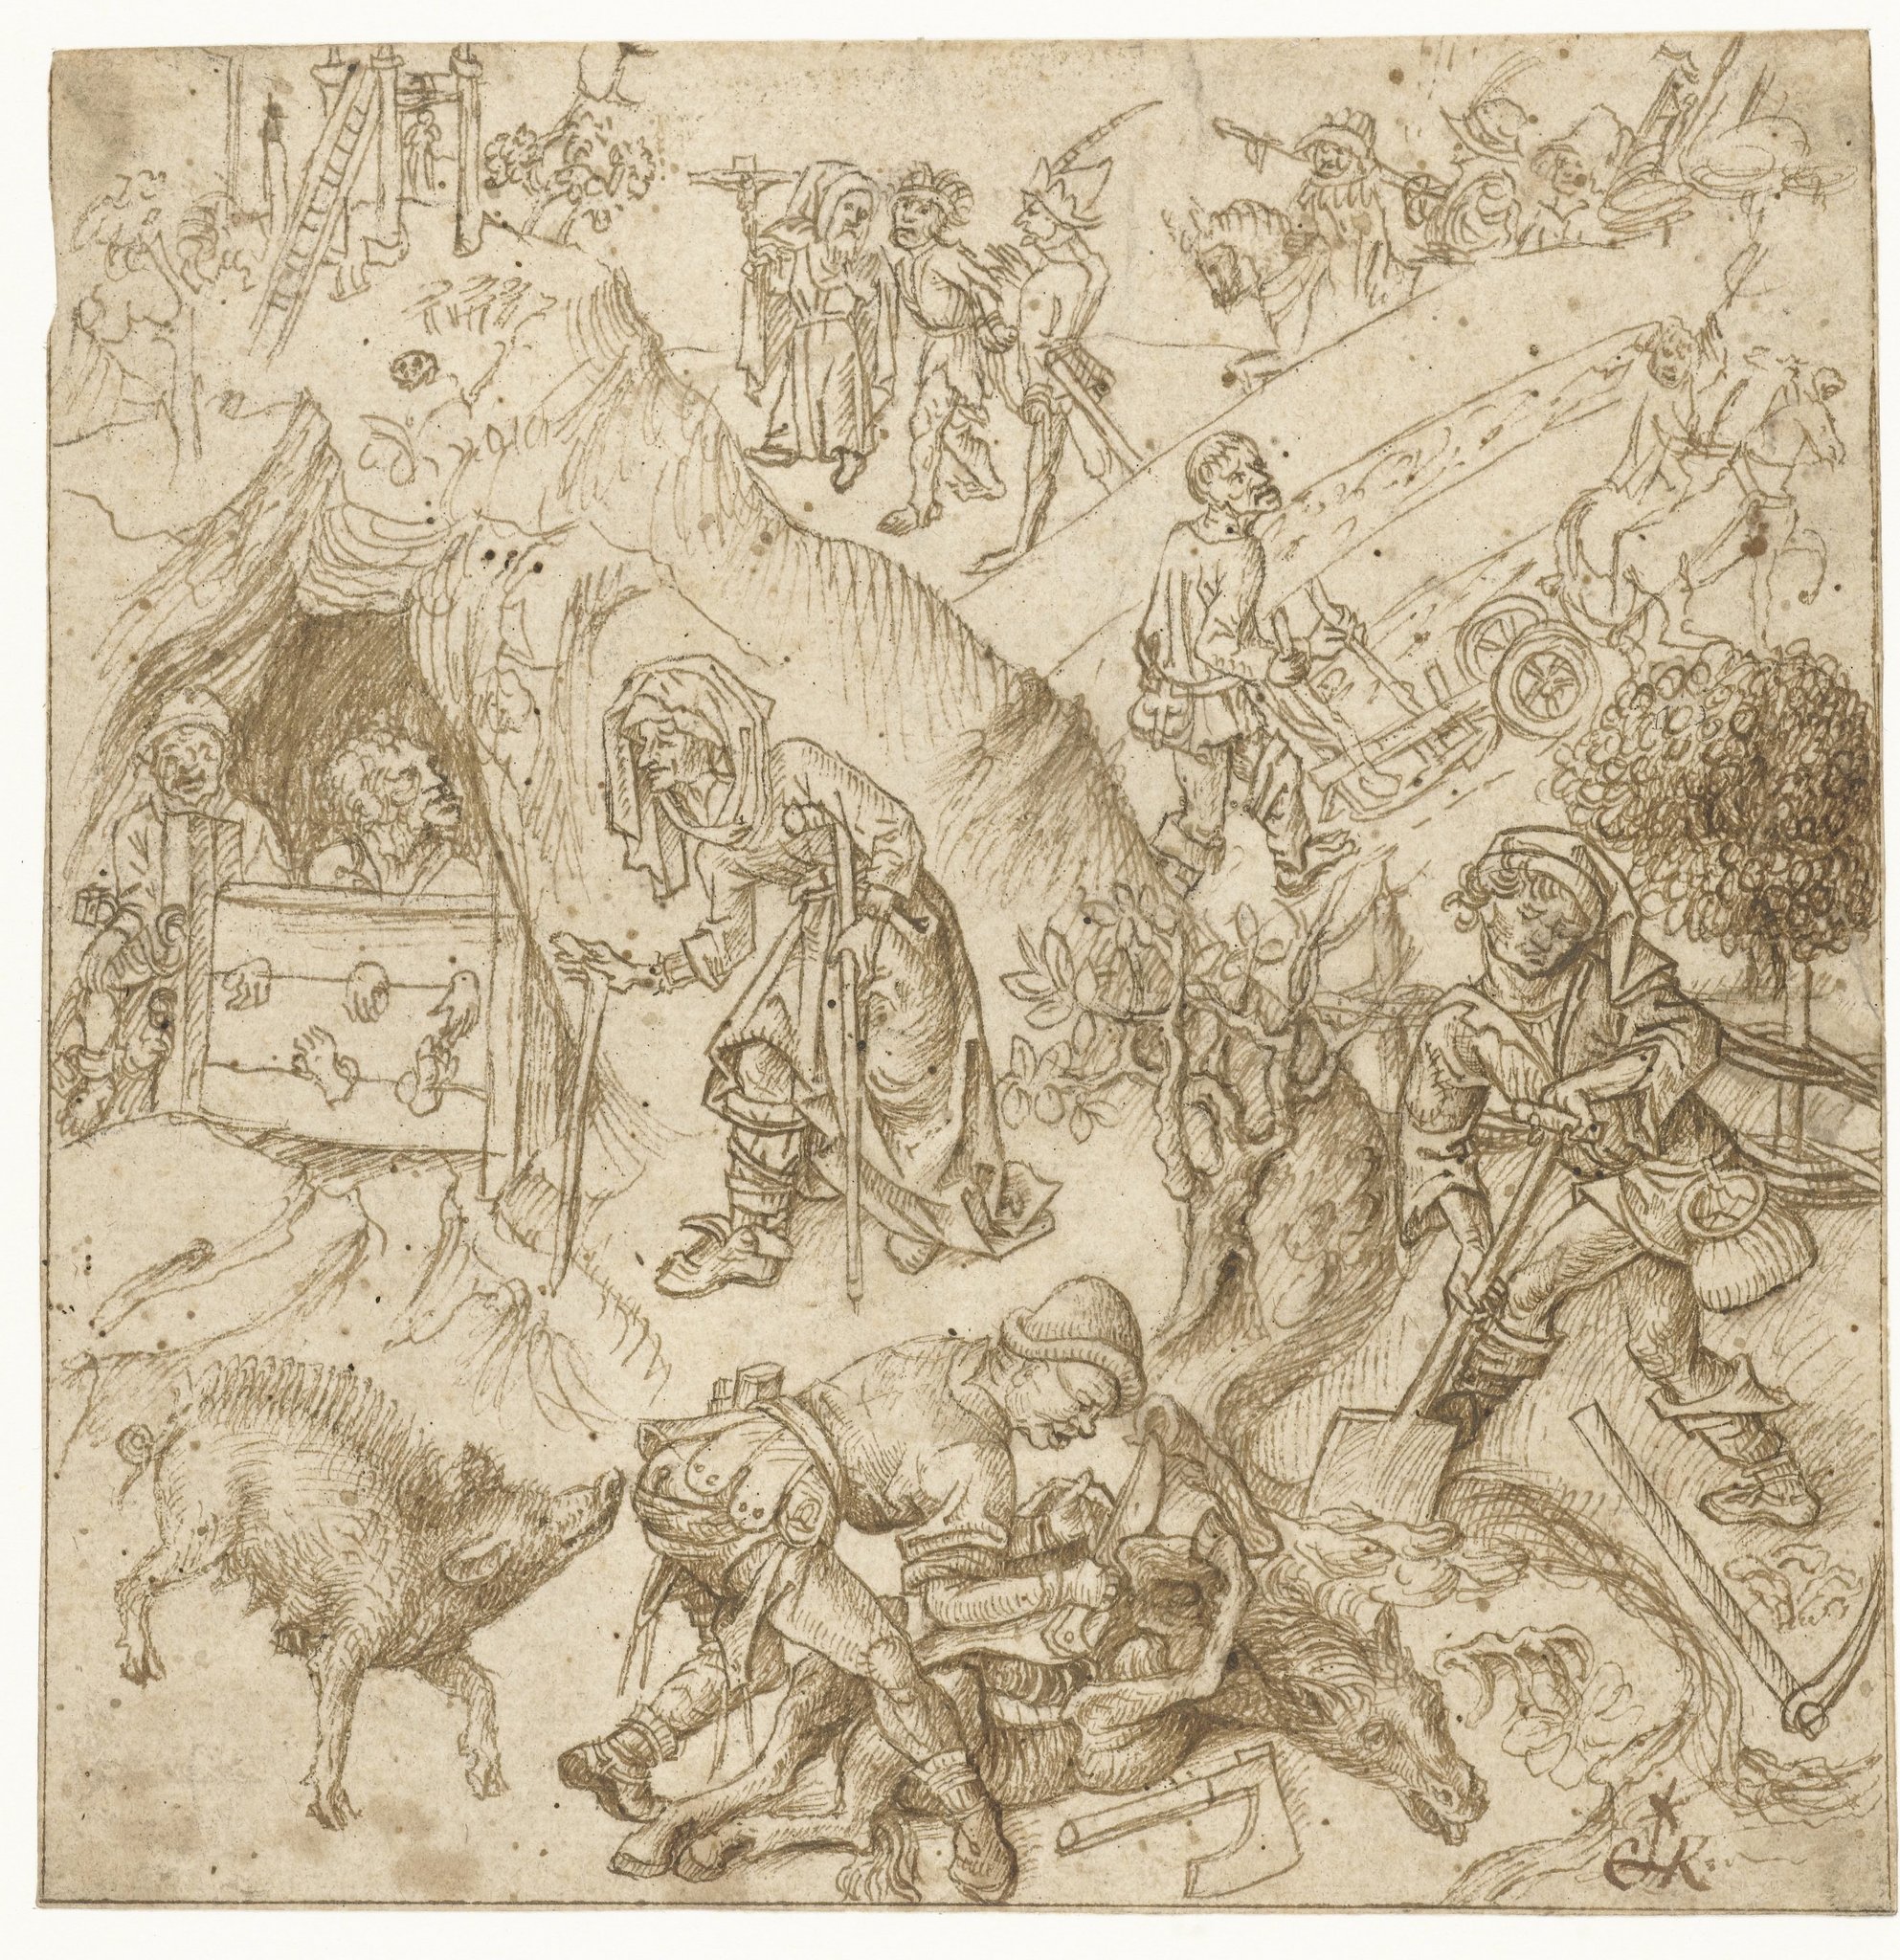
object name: drawing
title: De kinderen van Saturnus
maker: Anonymous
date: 1470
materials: ink, paper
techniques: pen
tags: saturn and his children ('planetenkinder') ~ aquarius and capricorn, (personifications of the) planets with their 'children', so-called 'planetenkinder'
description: Herhaling van één van de voorstellingen uit het 'Hausbuch' in het bezit van de vorst Truchsess von Waldburg-Wolfegg.